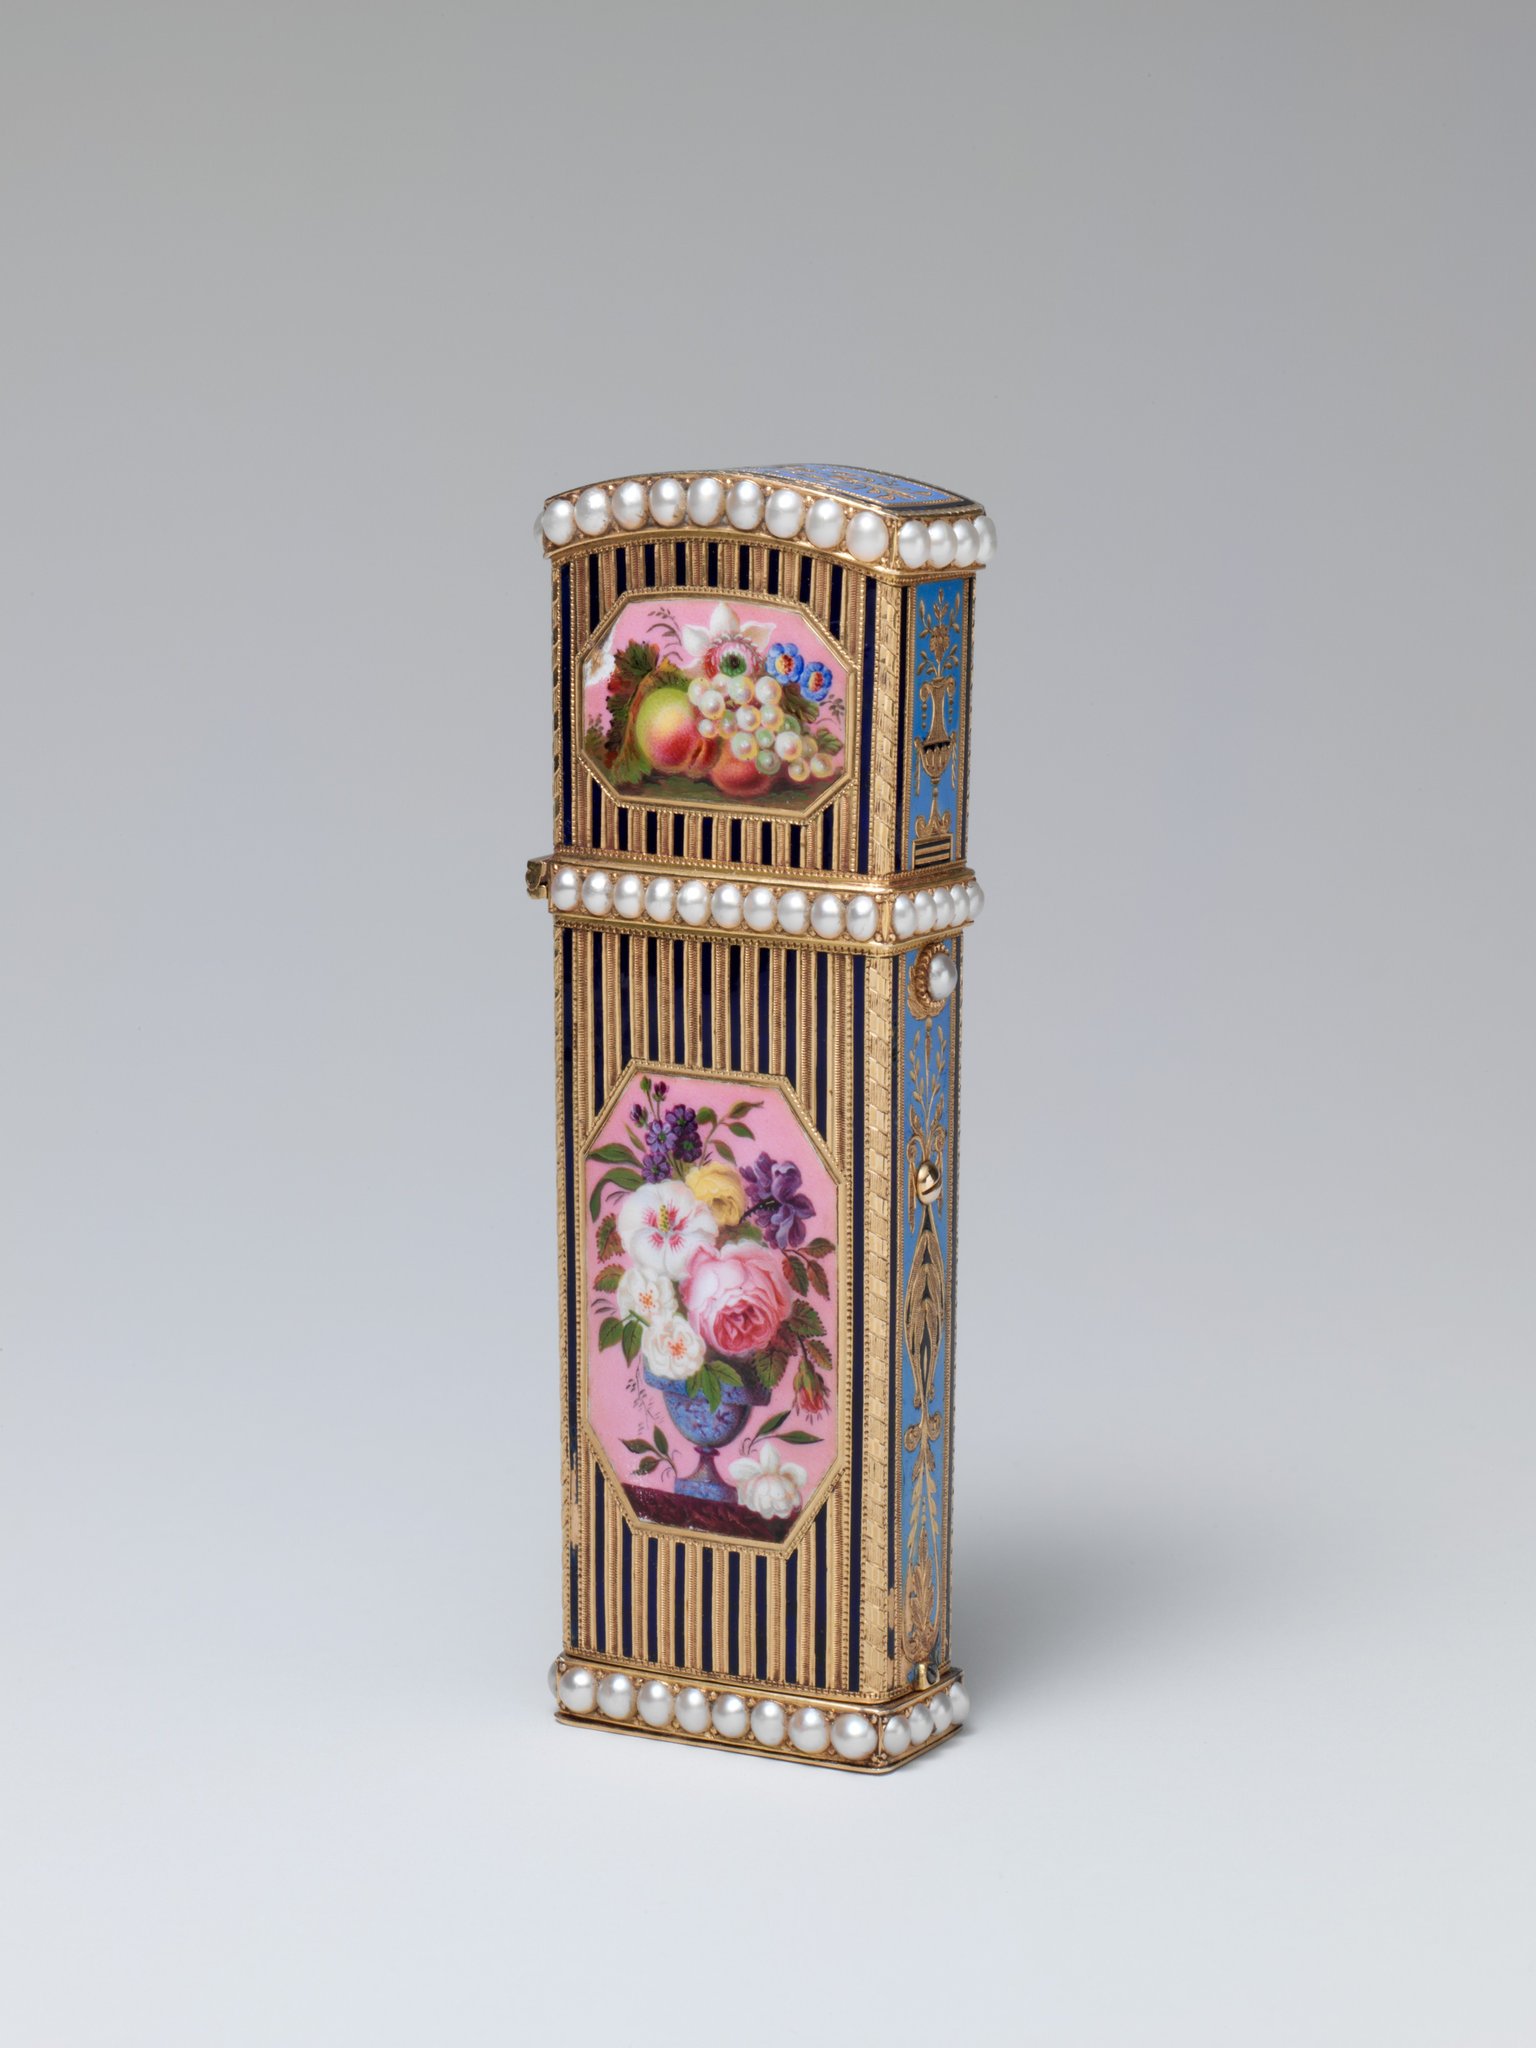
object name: music box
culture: french or swiss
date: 1801-1833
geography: france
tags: fruit,flowers